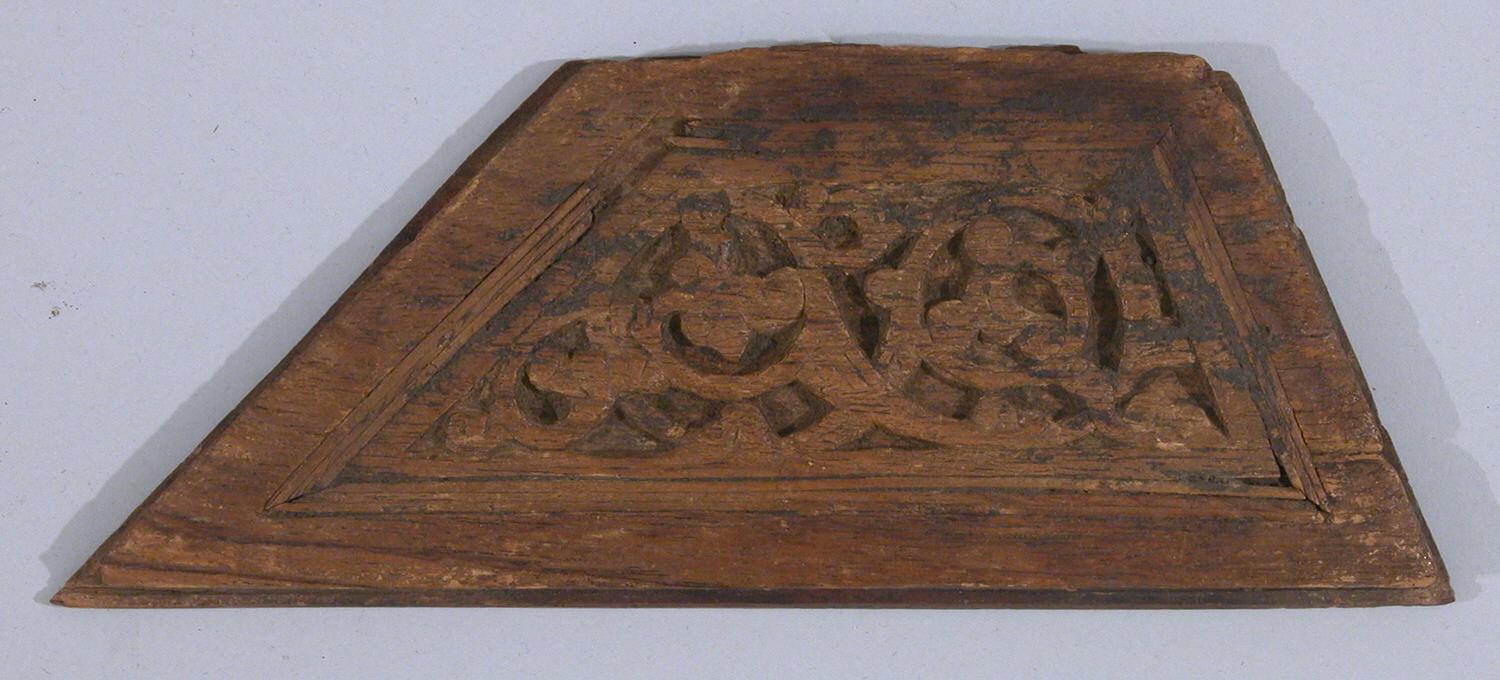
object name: panel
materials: wood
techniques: carving, inlay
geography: egypt